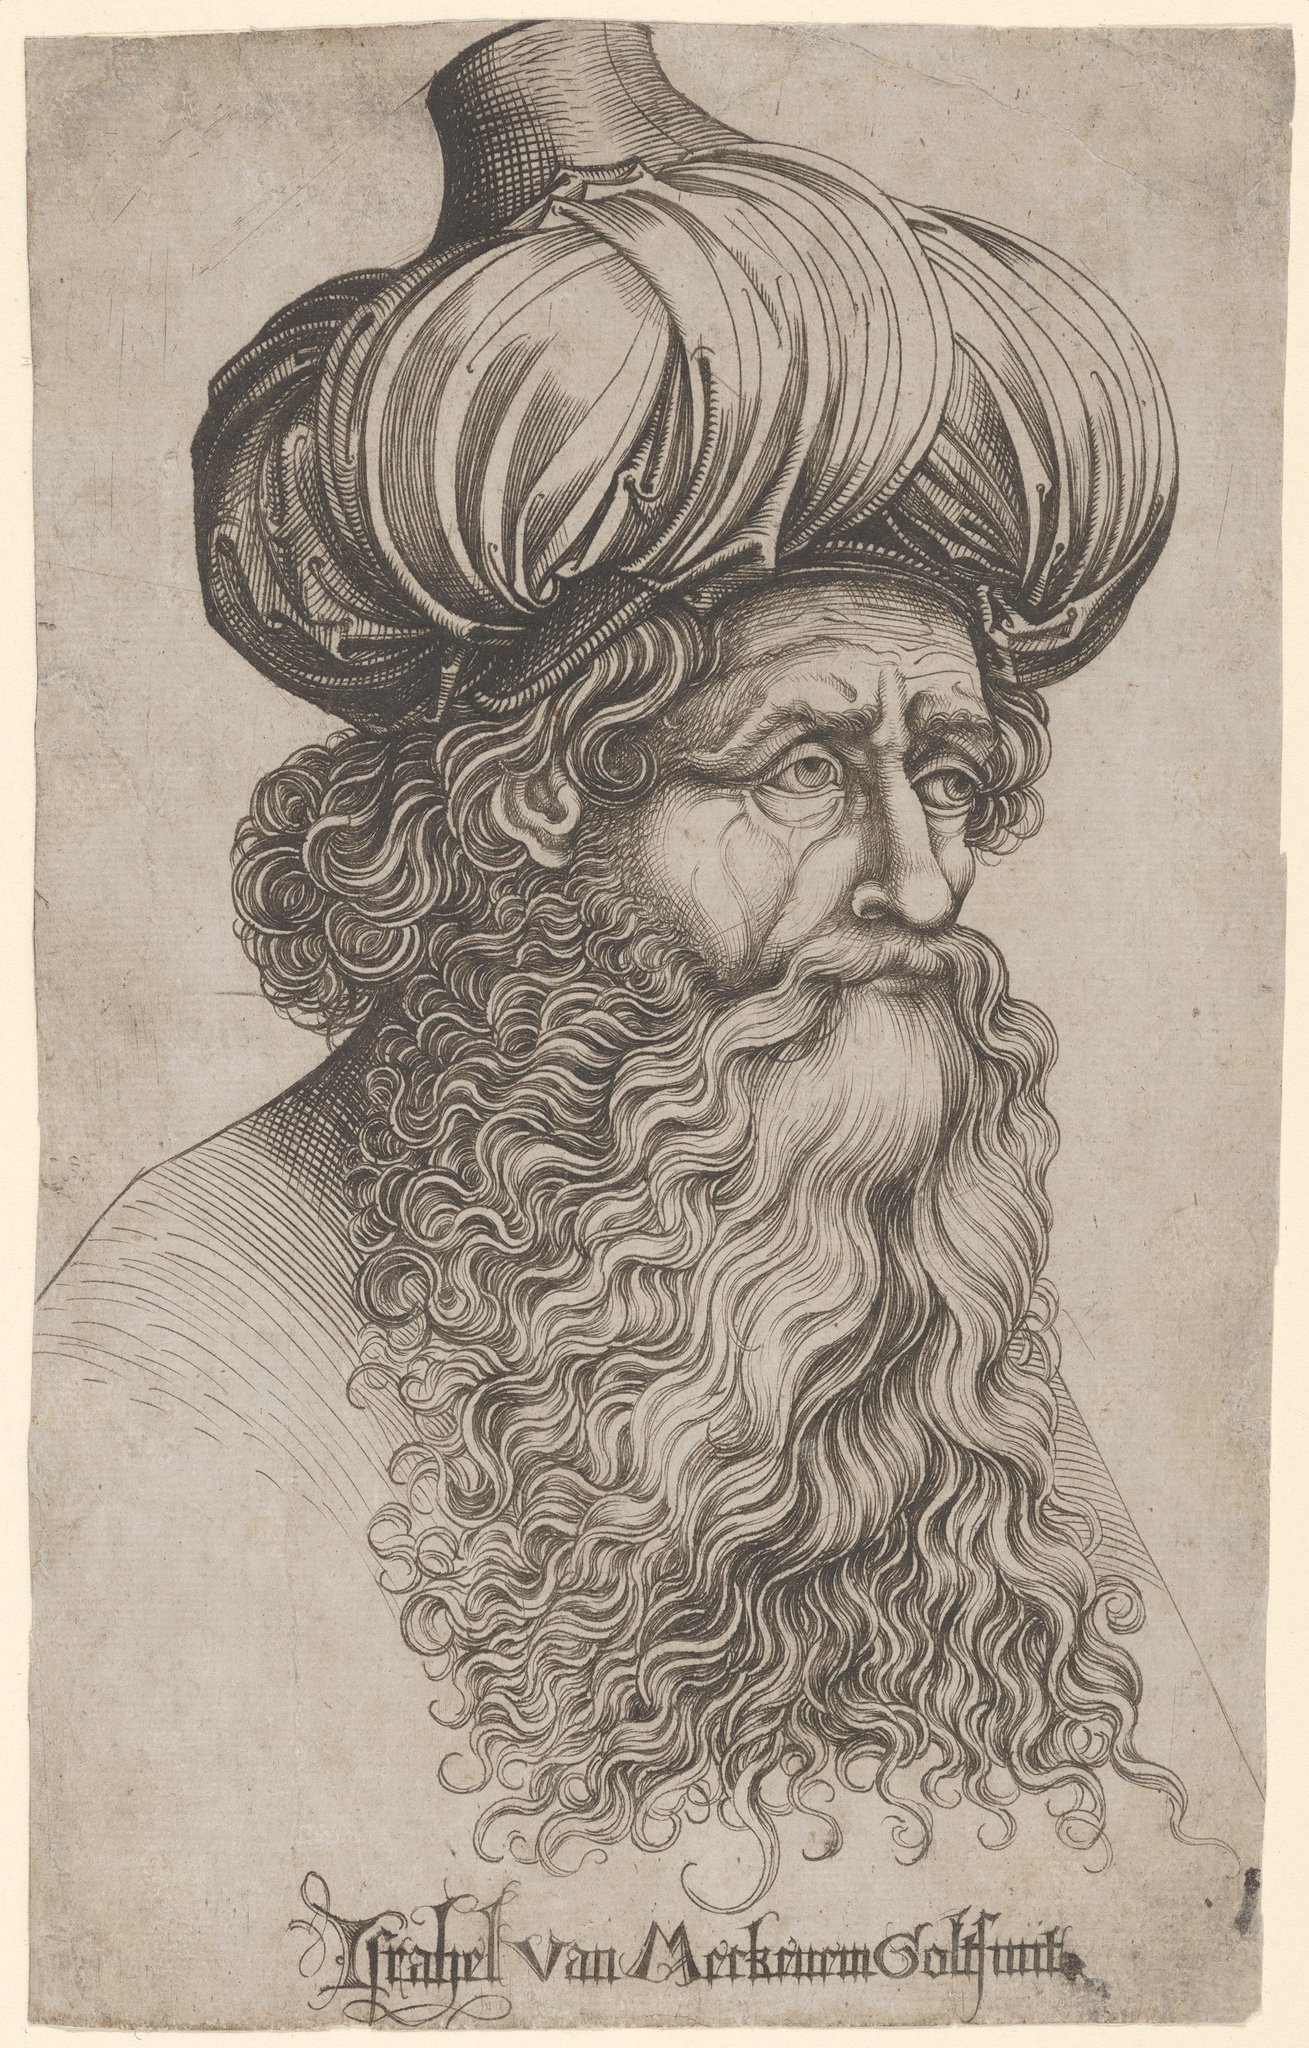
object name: print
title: Head of an Elderly Man with a Long Beard and Turban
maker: israhel van meckenem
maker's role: artist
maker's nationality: german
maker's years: 1435-1503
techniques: engraving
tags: heads,men,portraits